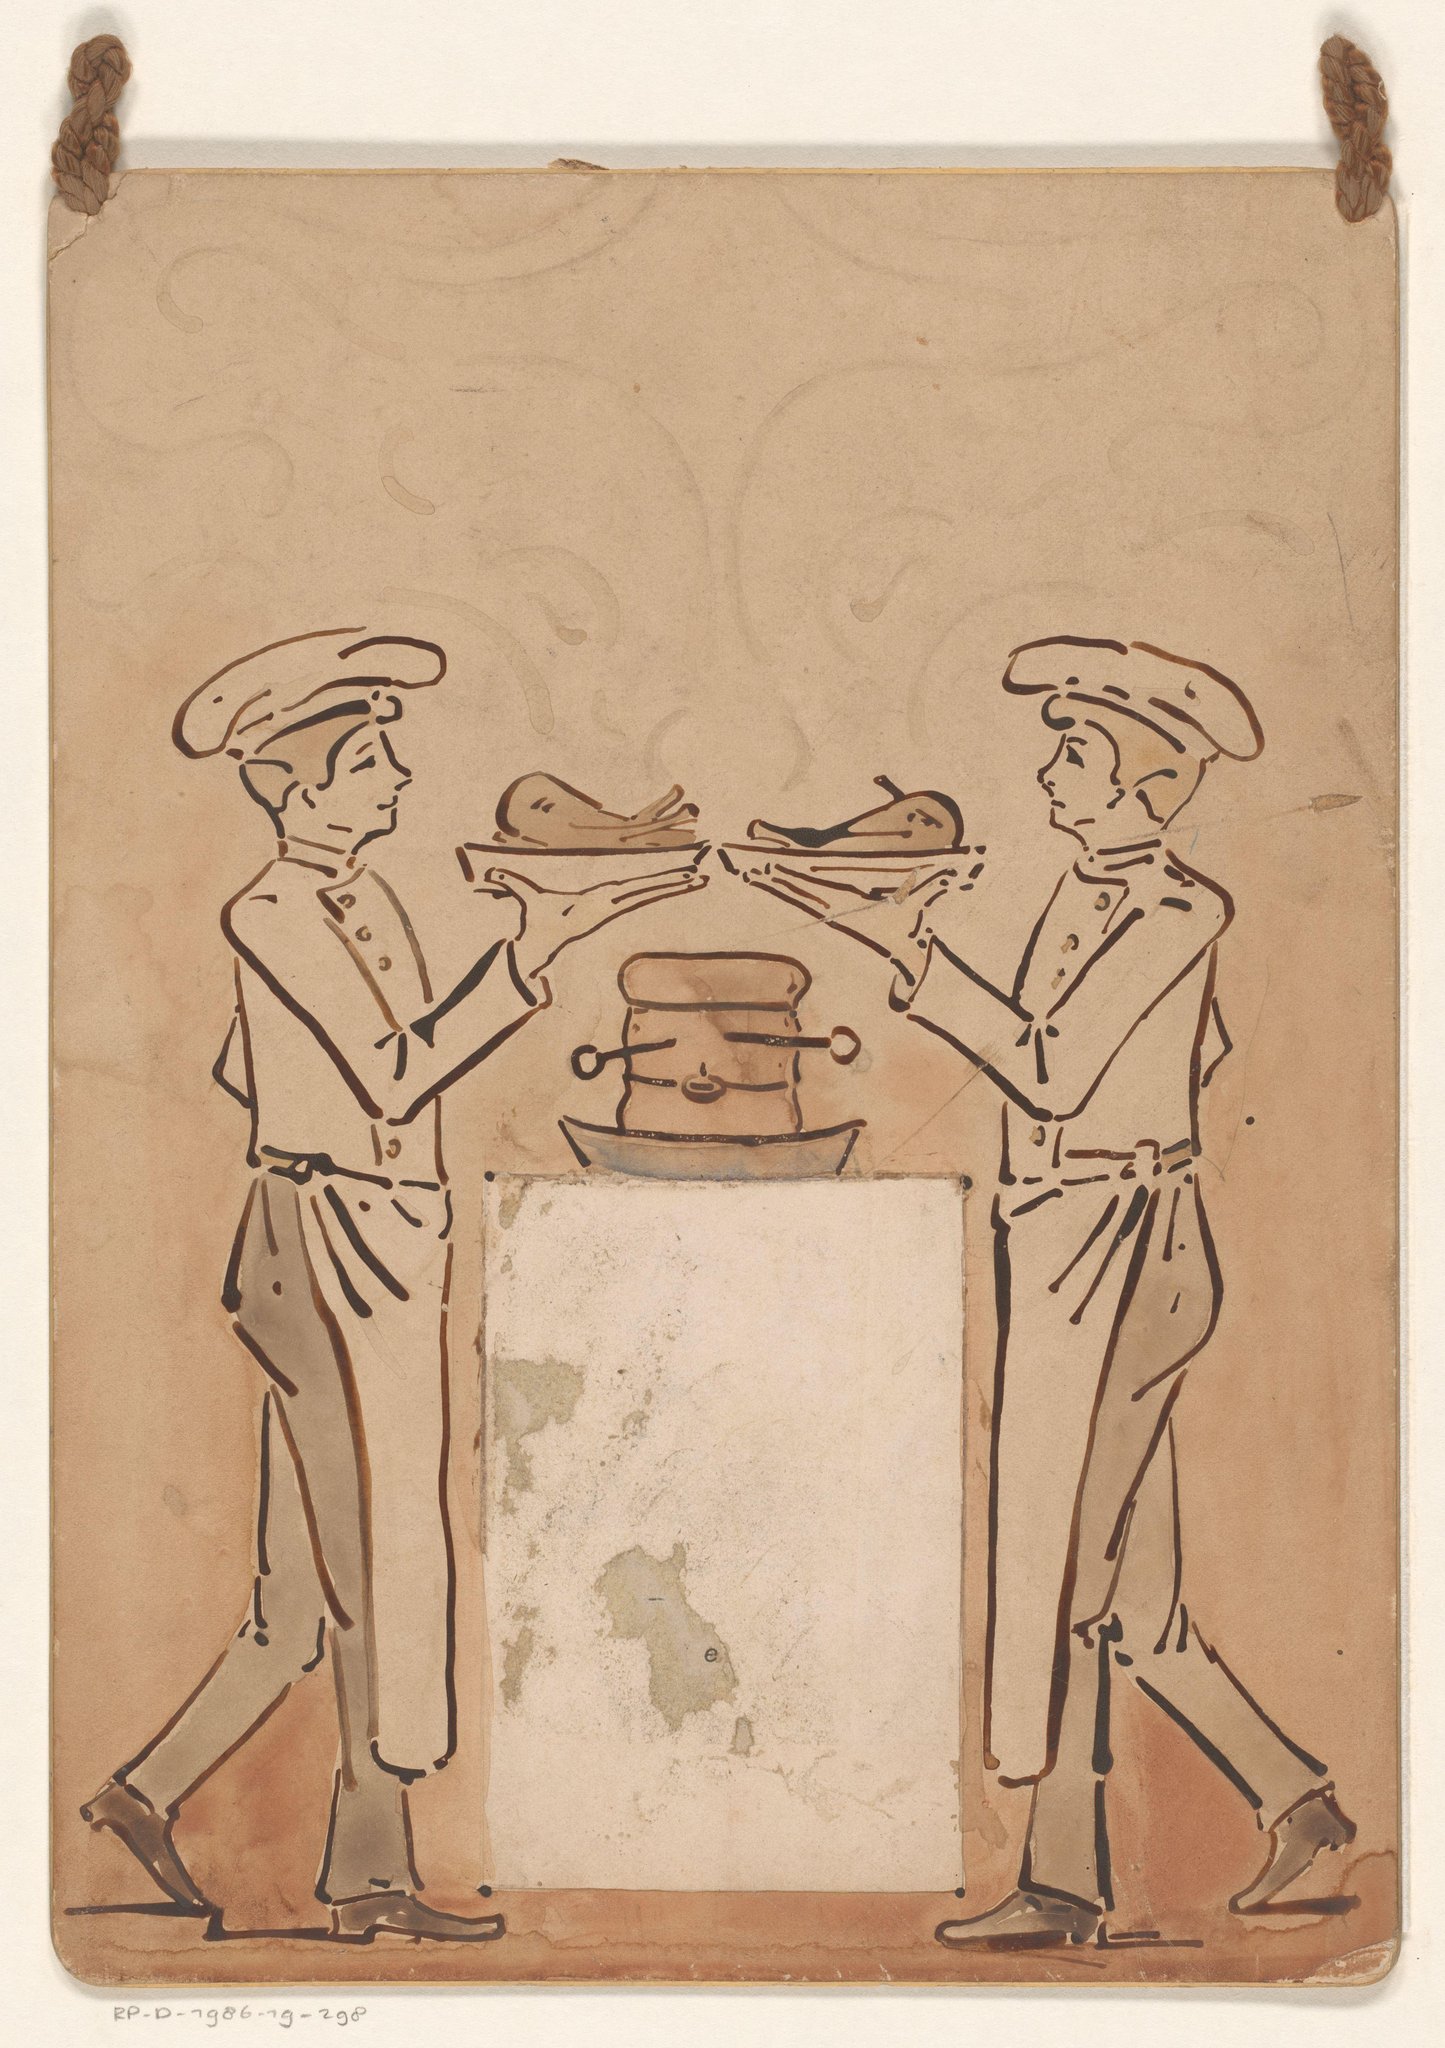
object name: design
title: Twee koks met dampende schalen vlees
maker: reinier willem petrus de vries (1874-1953)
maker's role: draughtsman, print maker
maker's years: 1874-1953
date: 1884-1952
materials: cardboard, ink, fiber, watercolor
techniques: brush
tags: cook, meat; still life of meat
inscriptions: collector's mark: ‘R:MVS.’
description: Mogelijk een ontwerp voor een reclamebord. Het bord kan worden opgehangen aan de twee lussen die aan de bovenkant aan het karton zijn bevestigd.